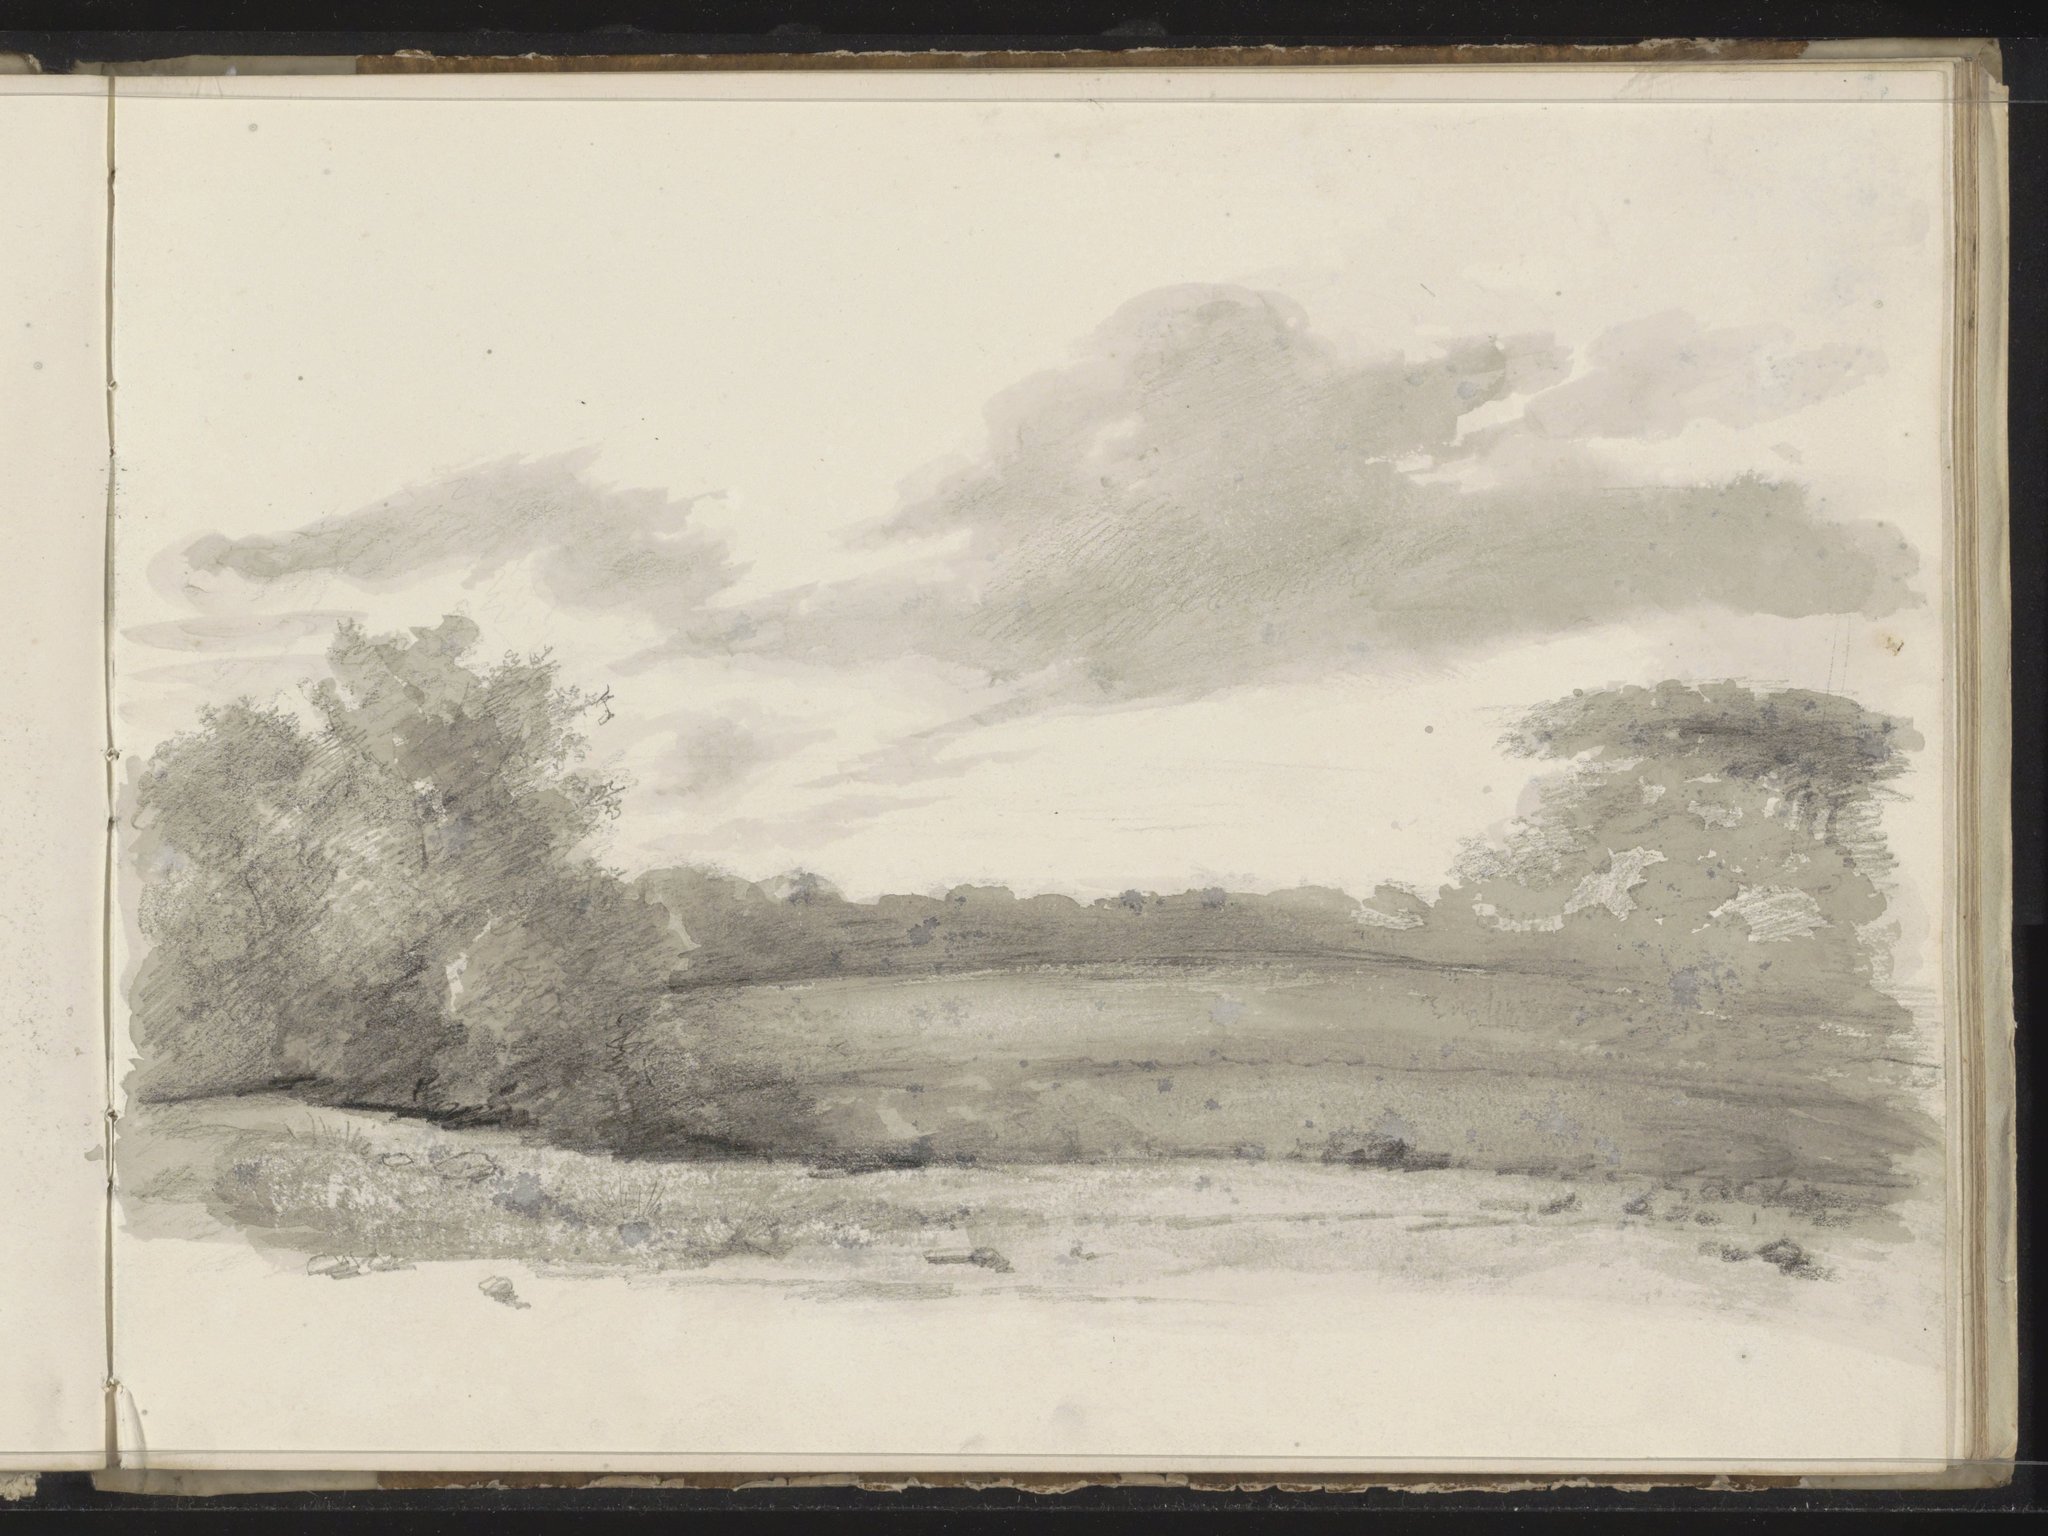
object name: sketchbook leaf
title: Landschap met bomen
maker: maria vos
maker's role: draughtsman, painter, print maker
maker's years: 1824-1906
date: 1834-1906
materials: paper, pencil, watercolor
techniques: brush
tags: landscapes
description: Blad 14 recto uit een schetsboek met 39 bladen.